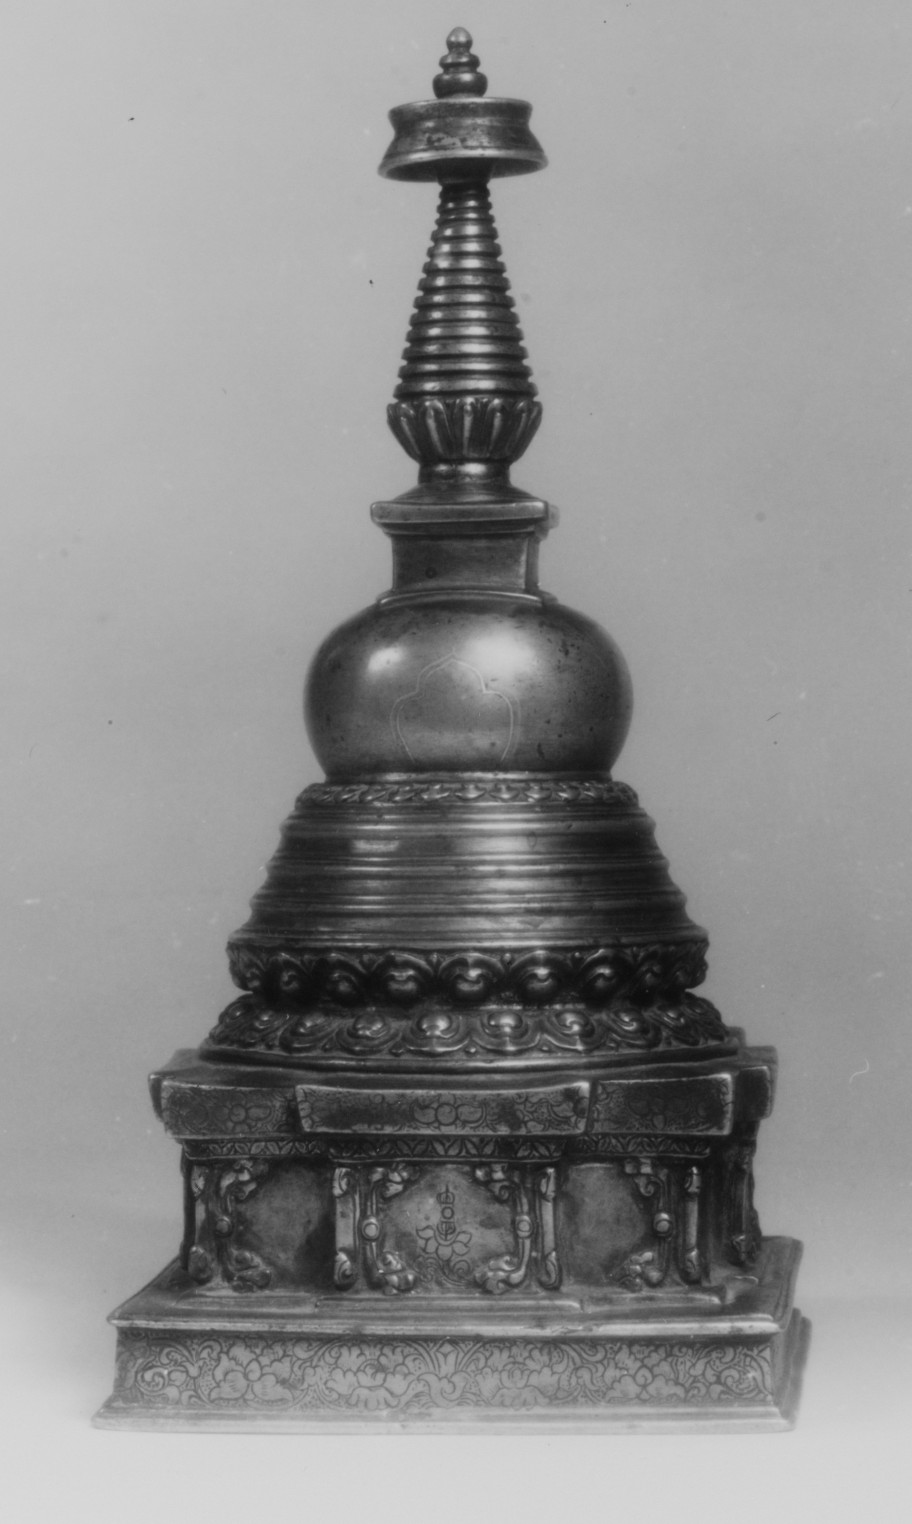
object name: stupa model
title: Model of a Stupa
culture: tibetan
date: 1401-1500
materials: bronze, copper, silver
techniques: inlay